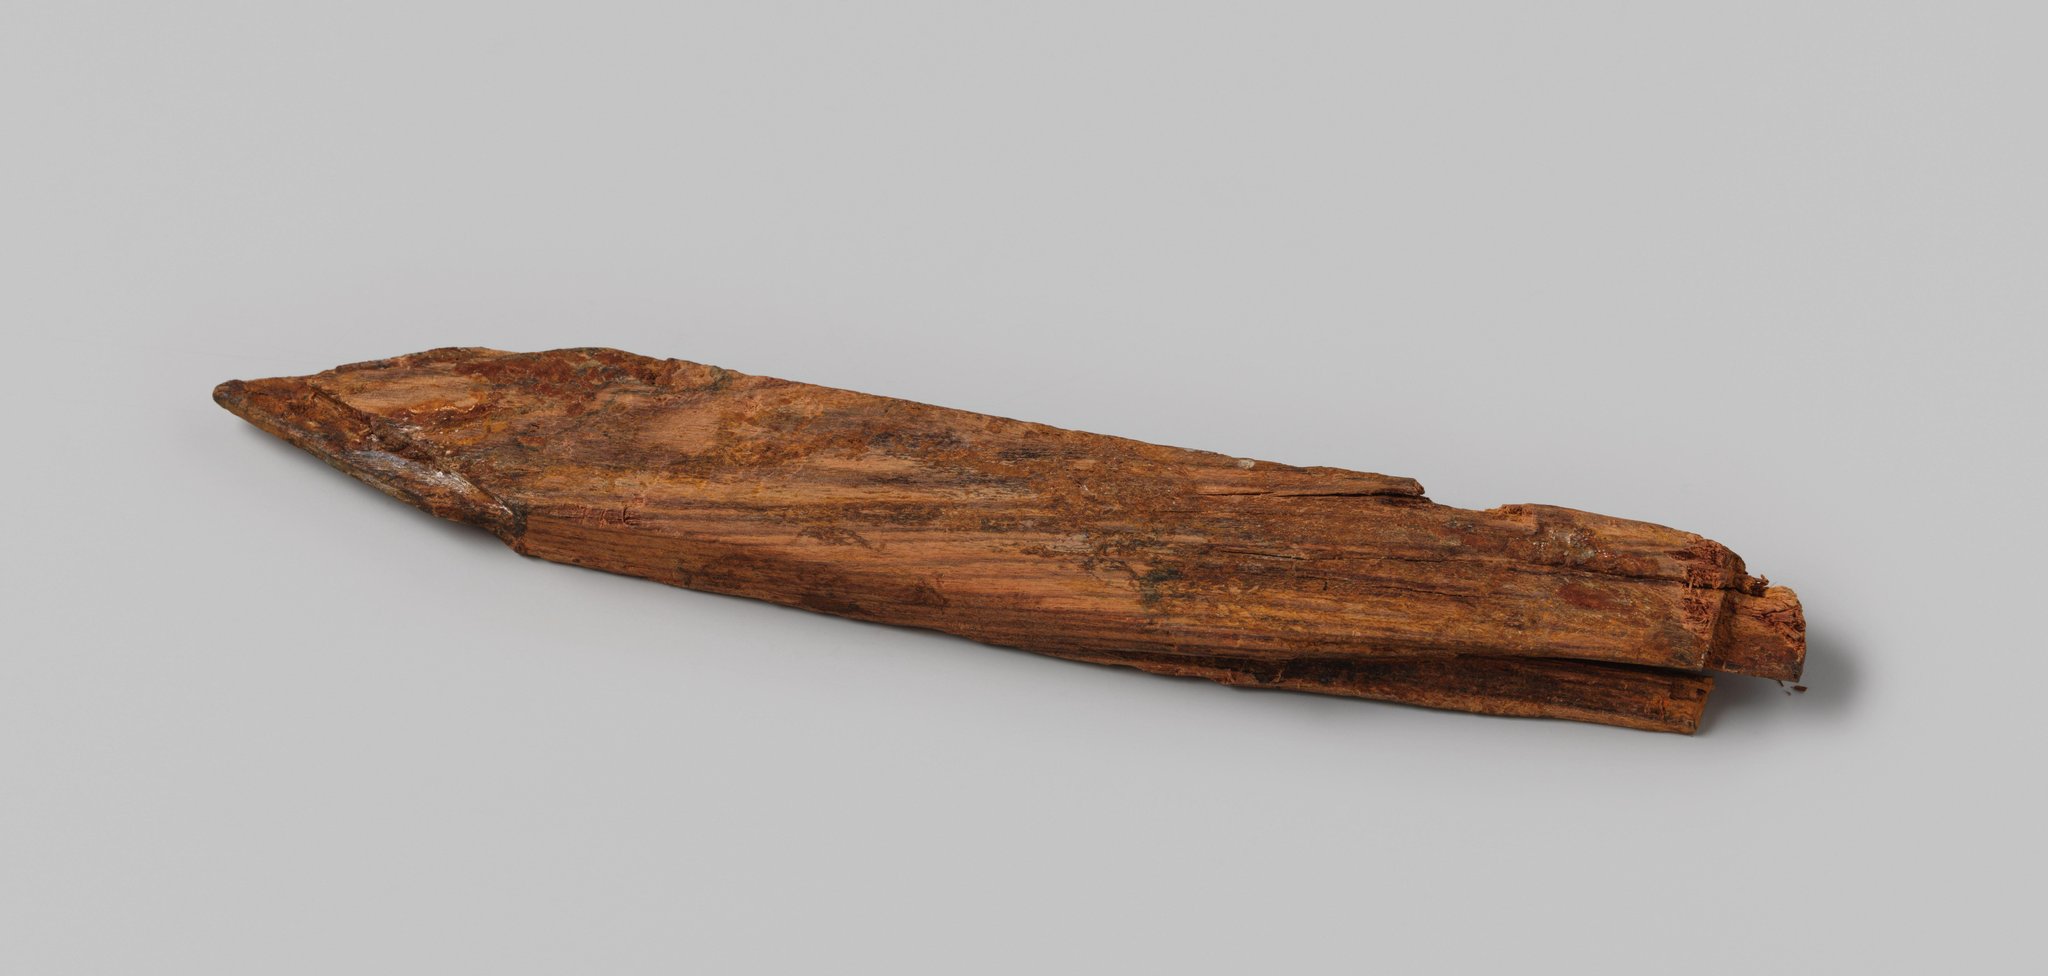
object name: fragment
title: Fragment van hout uit het wrak van de Oost-Indiëvaarder Hollandia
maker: Anonymous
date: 1700-1743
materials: wood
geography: netherlands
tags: verenigde oostindische compagnie, hollandia (schip), annet